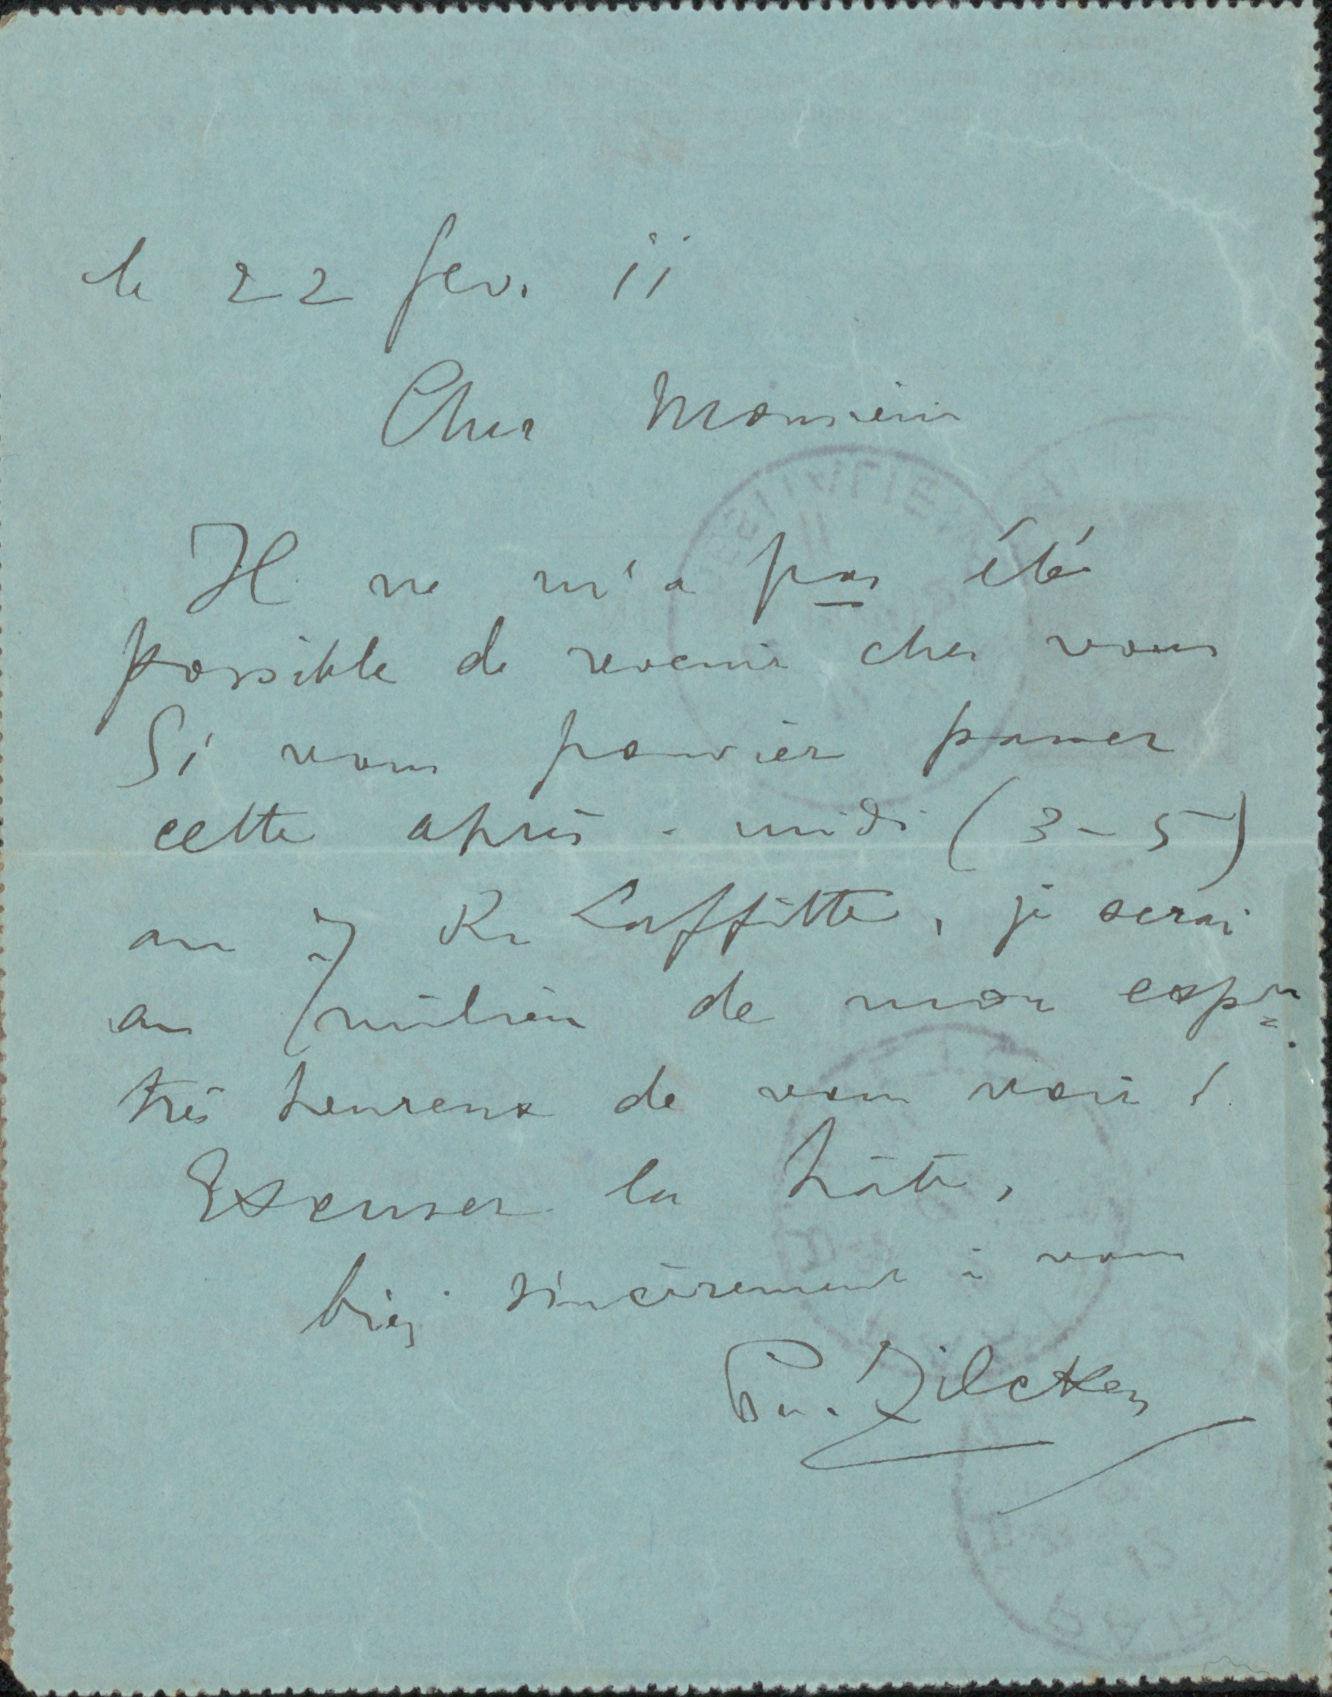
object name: postcard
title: Briefkaart aan Gustave Kahn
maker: philip zilcken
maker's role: draughtsman, painter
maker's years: 1857-1930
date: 1911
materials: cardboard, ink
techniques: pen, writing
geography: paris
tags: paris, gustave kahn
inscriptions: collector's mark: ‘RPK’